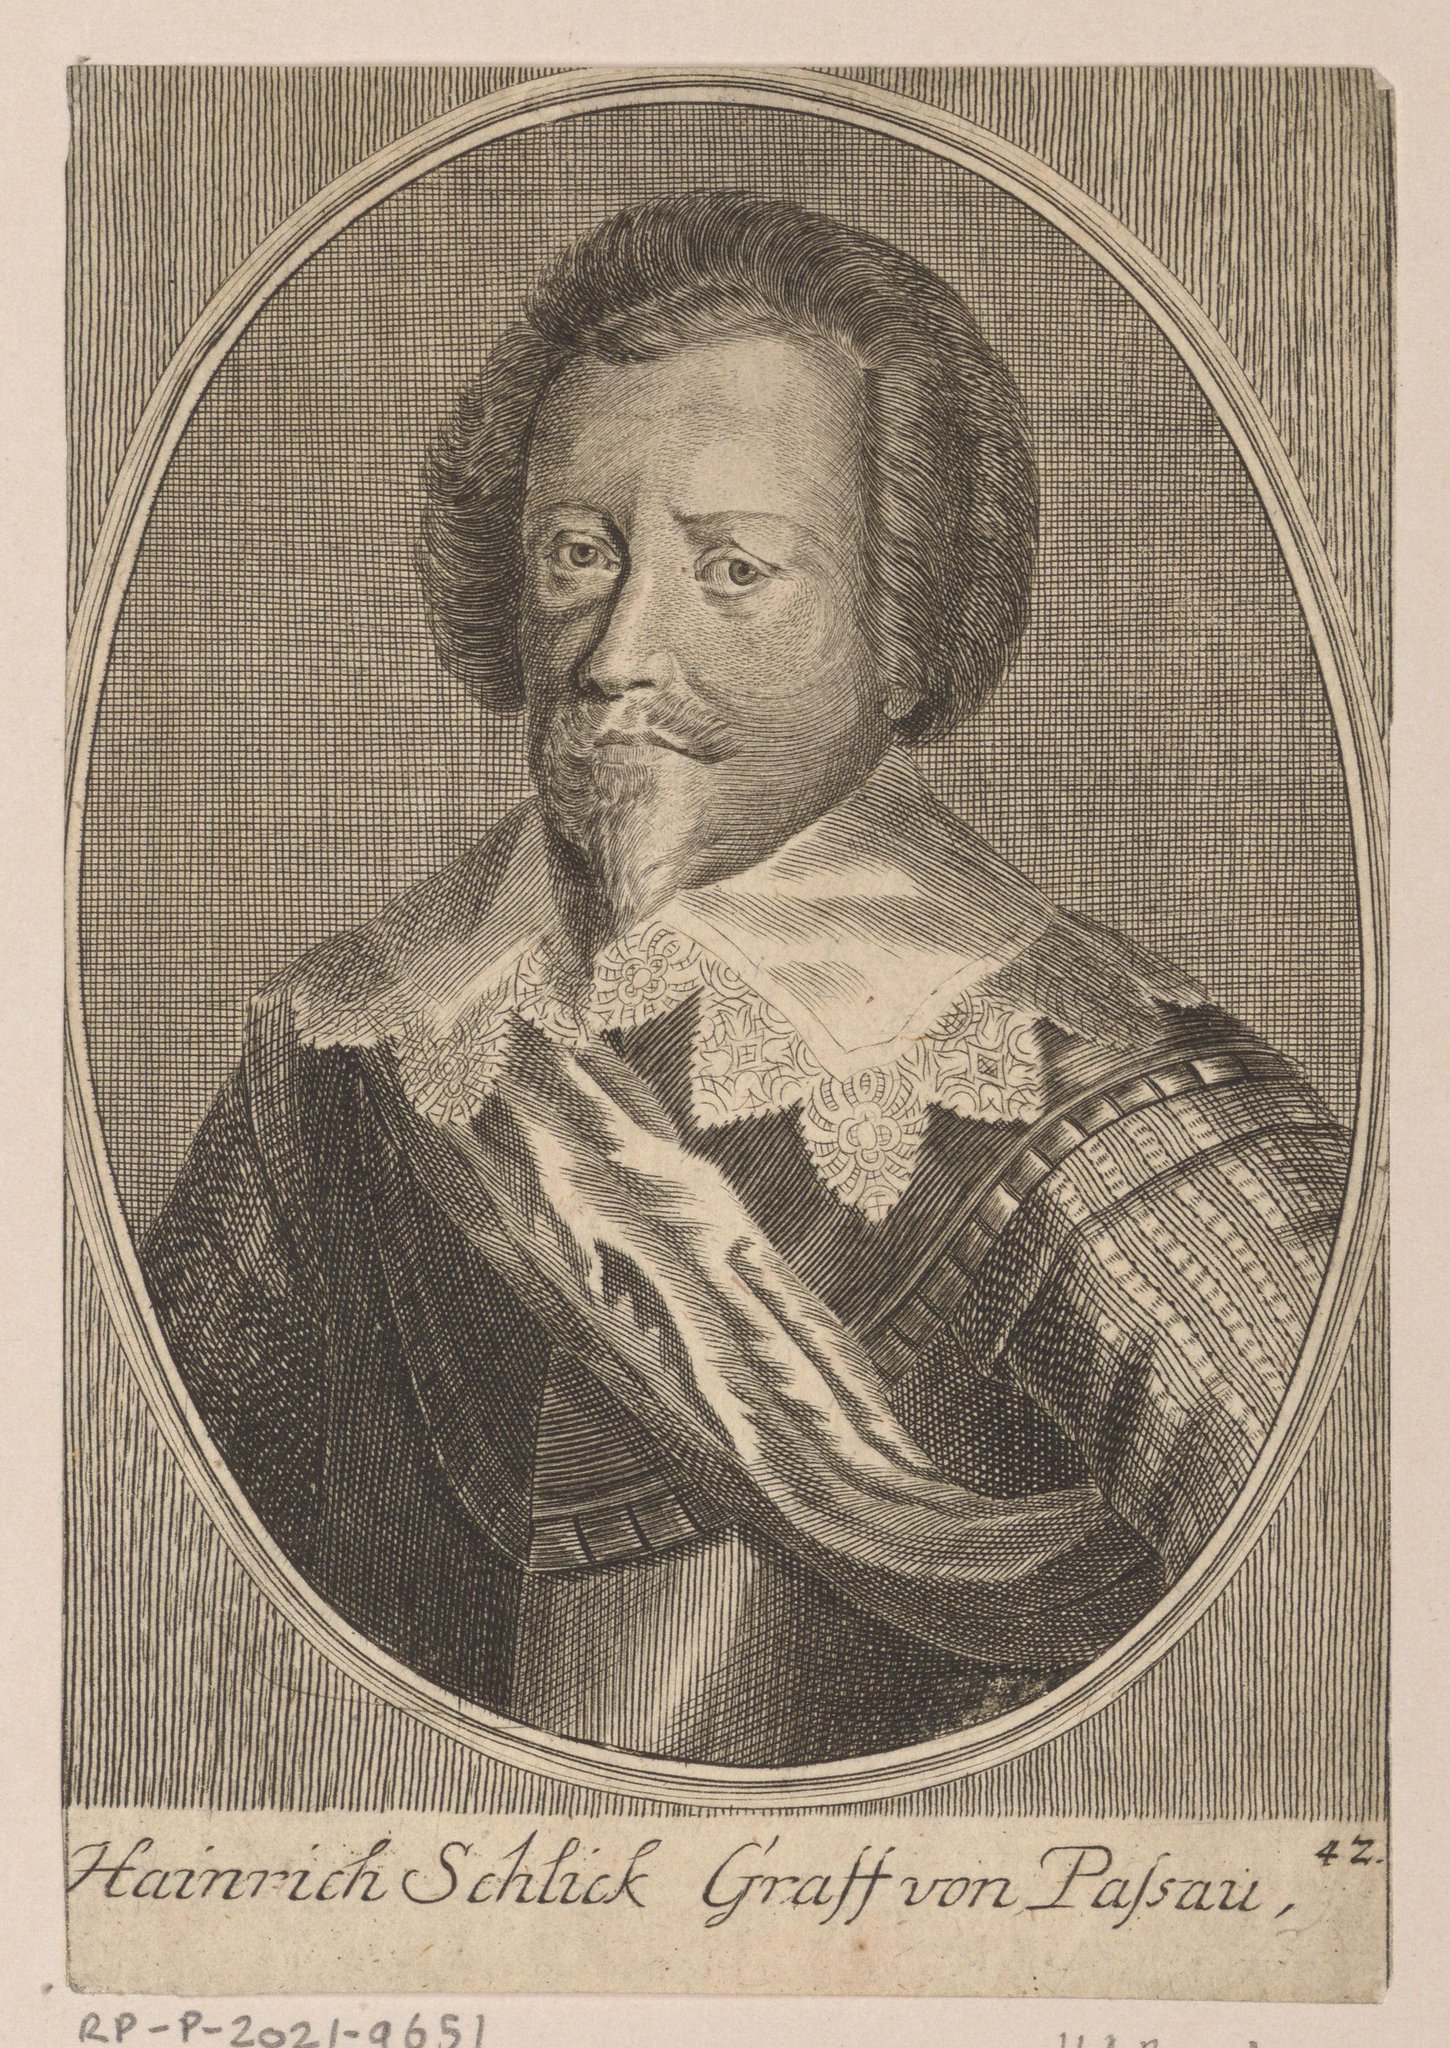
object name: print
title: Portret van Heinrich Schlick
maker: Anonymous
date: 1722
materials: paper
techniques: engraving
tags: vienna, earl, commander-in-chief, general, marshal, historical persons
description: Prent met omlijsting gebruikt in: Khevenhüller, Franz Christoph. Conterfet Kupfferstich (...). Leipzig: Moritz Georg Weidmann, 1722, dl. 2.